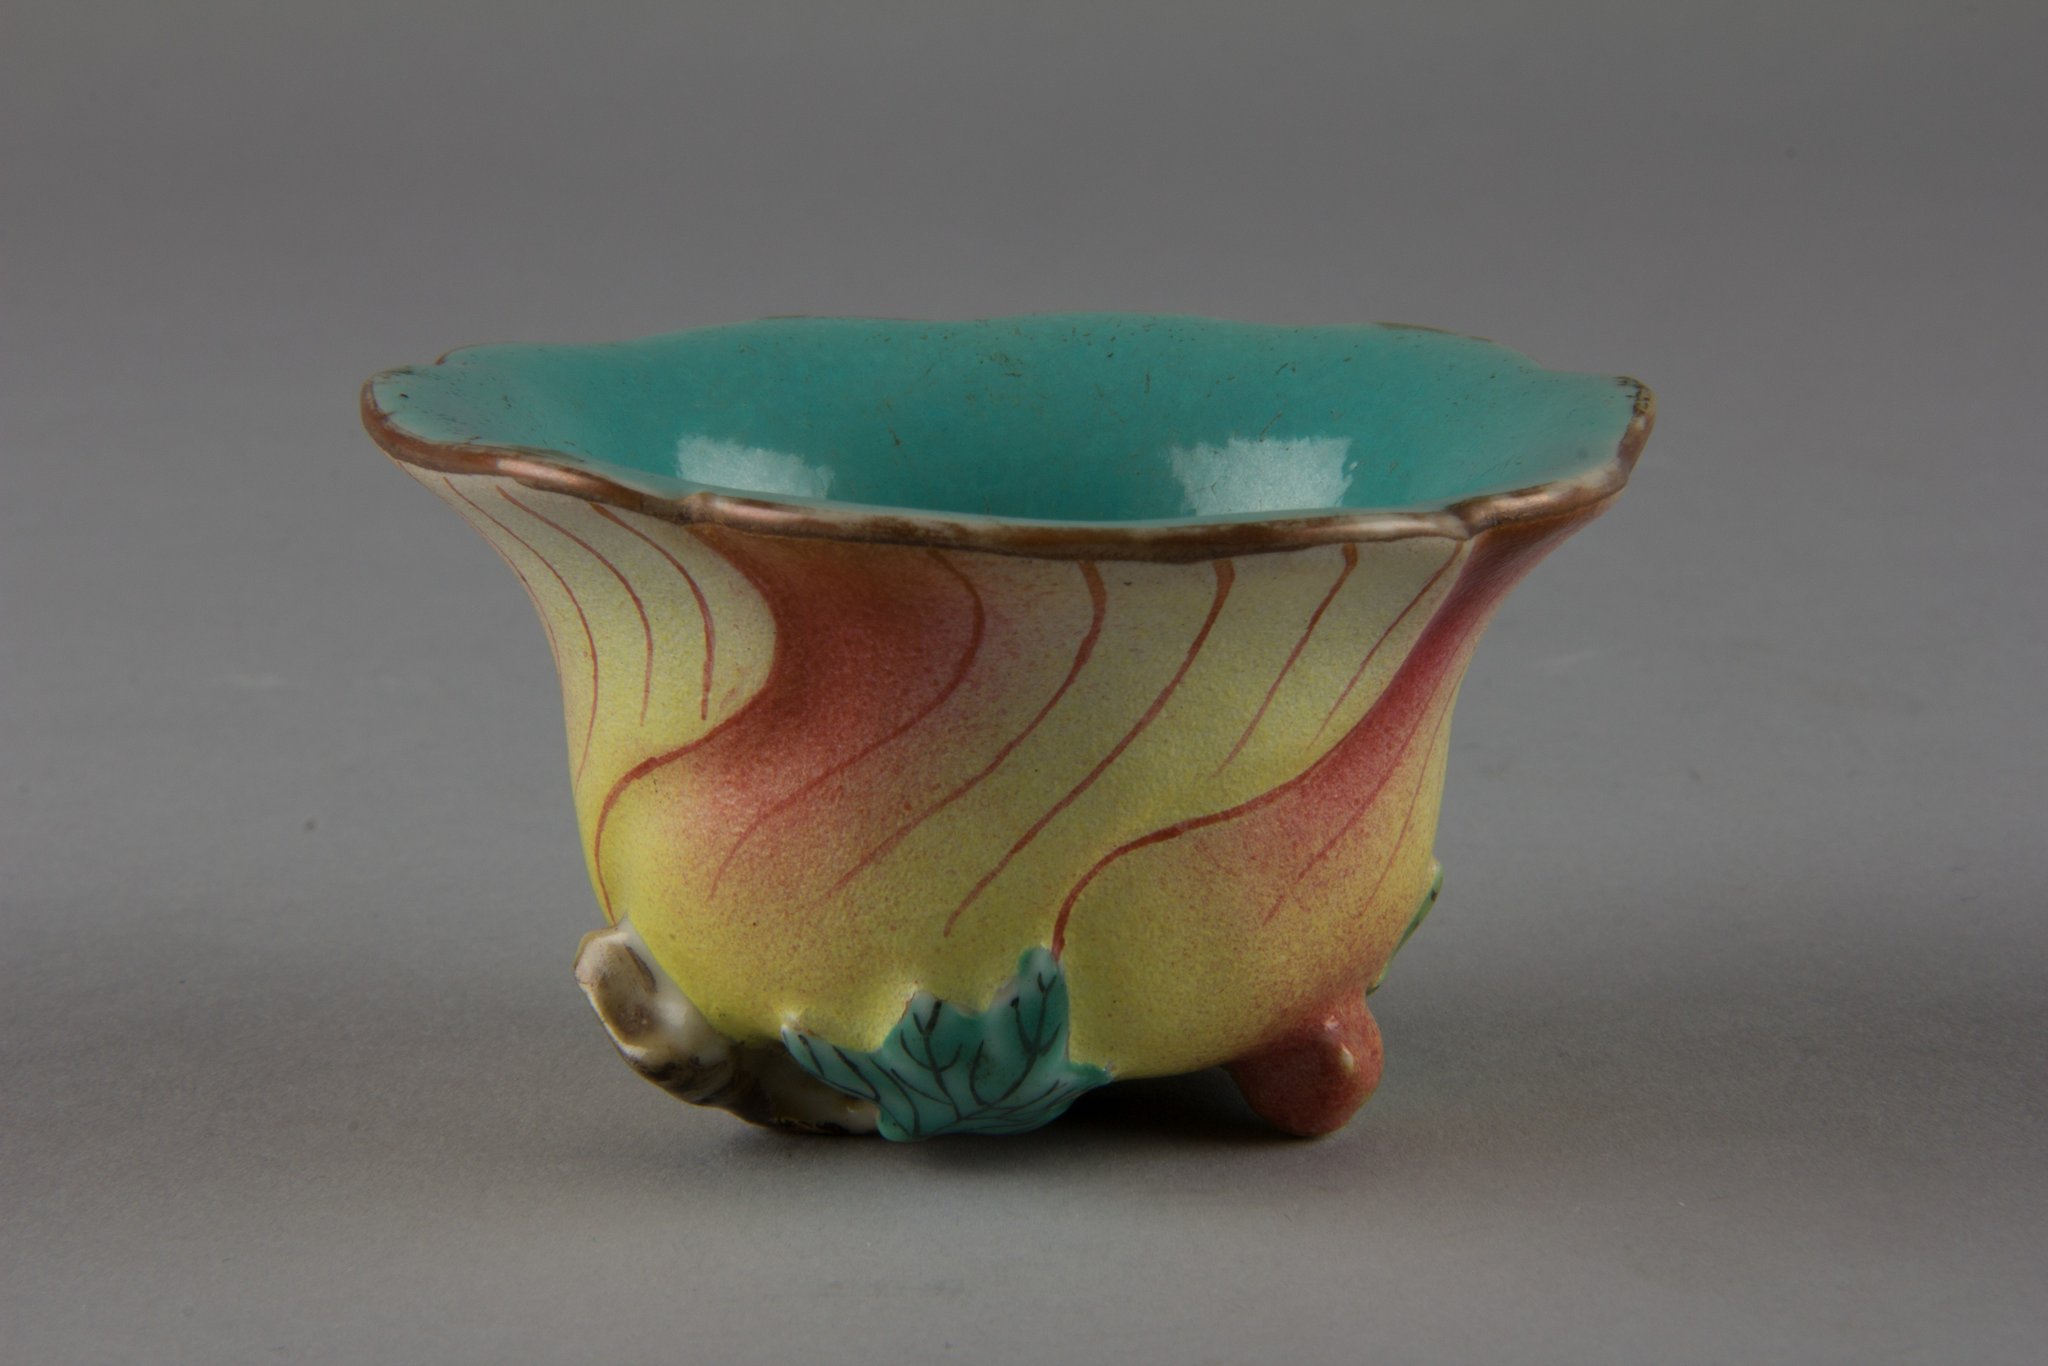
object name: cup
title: Magnolia cup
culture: chinese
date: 1767-1800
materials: enamel, porcelain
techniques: overglaze, painting, polychrome